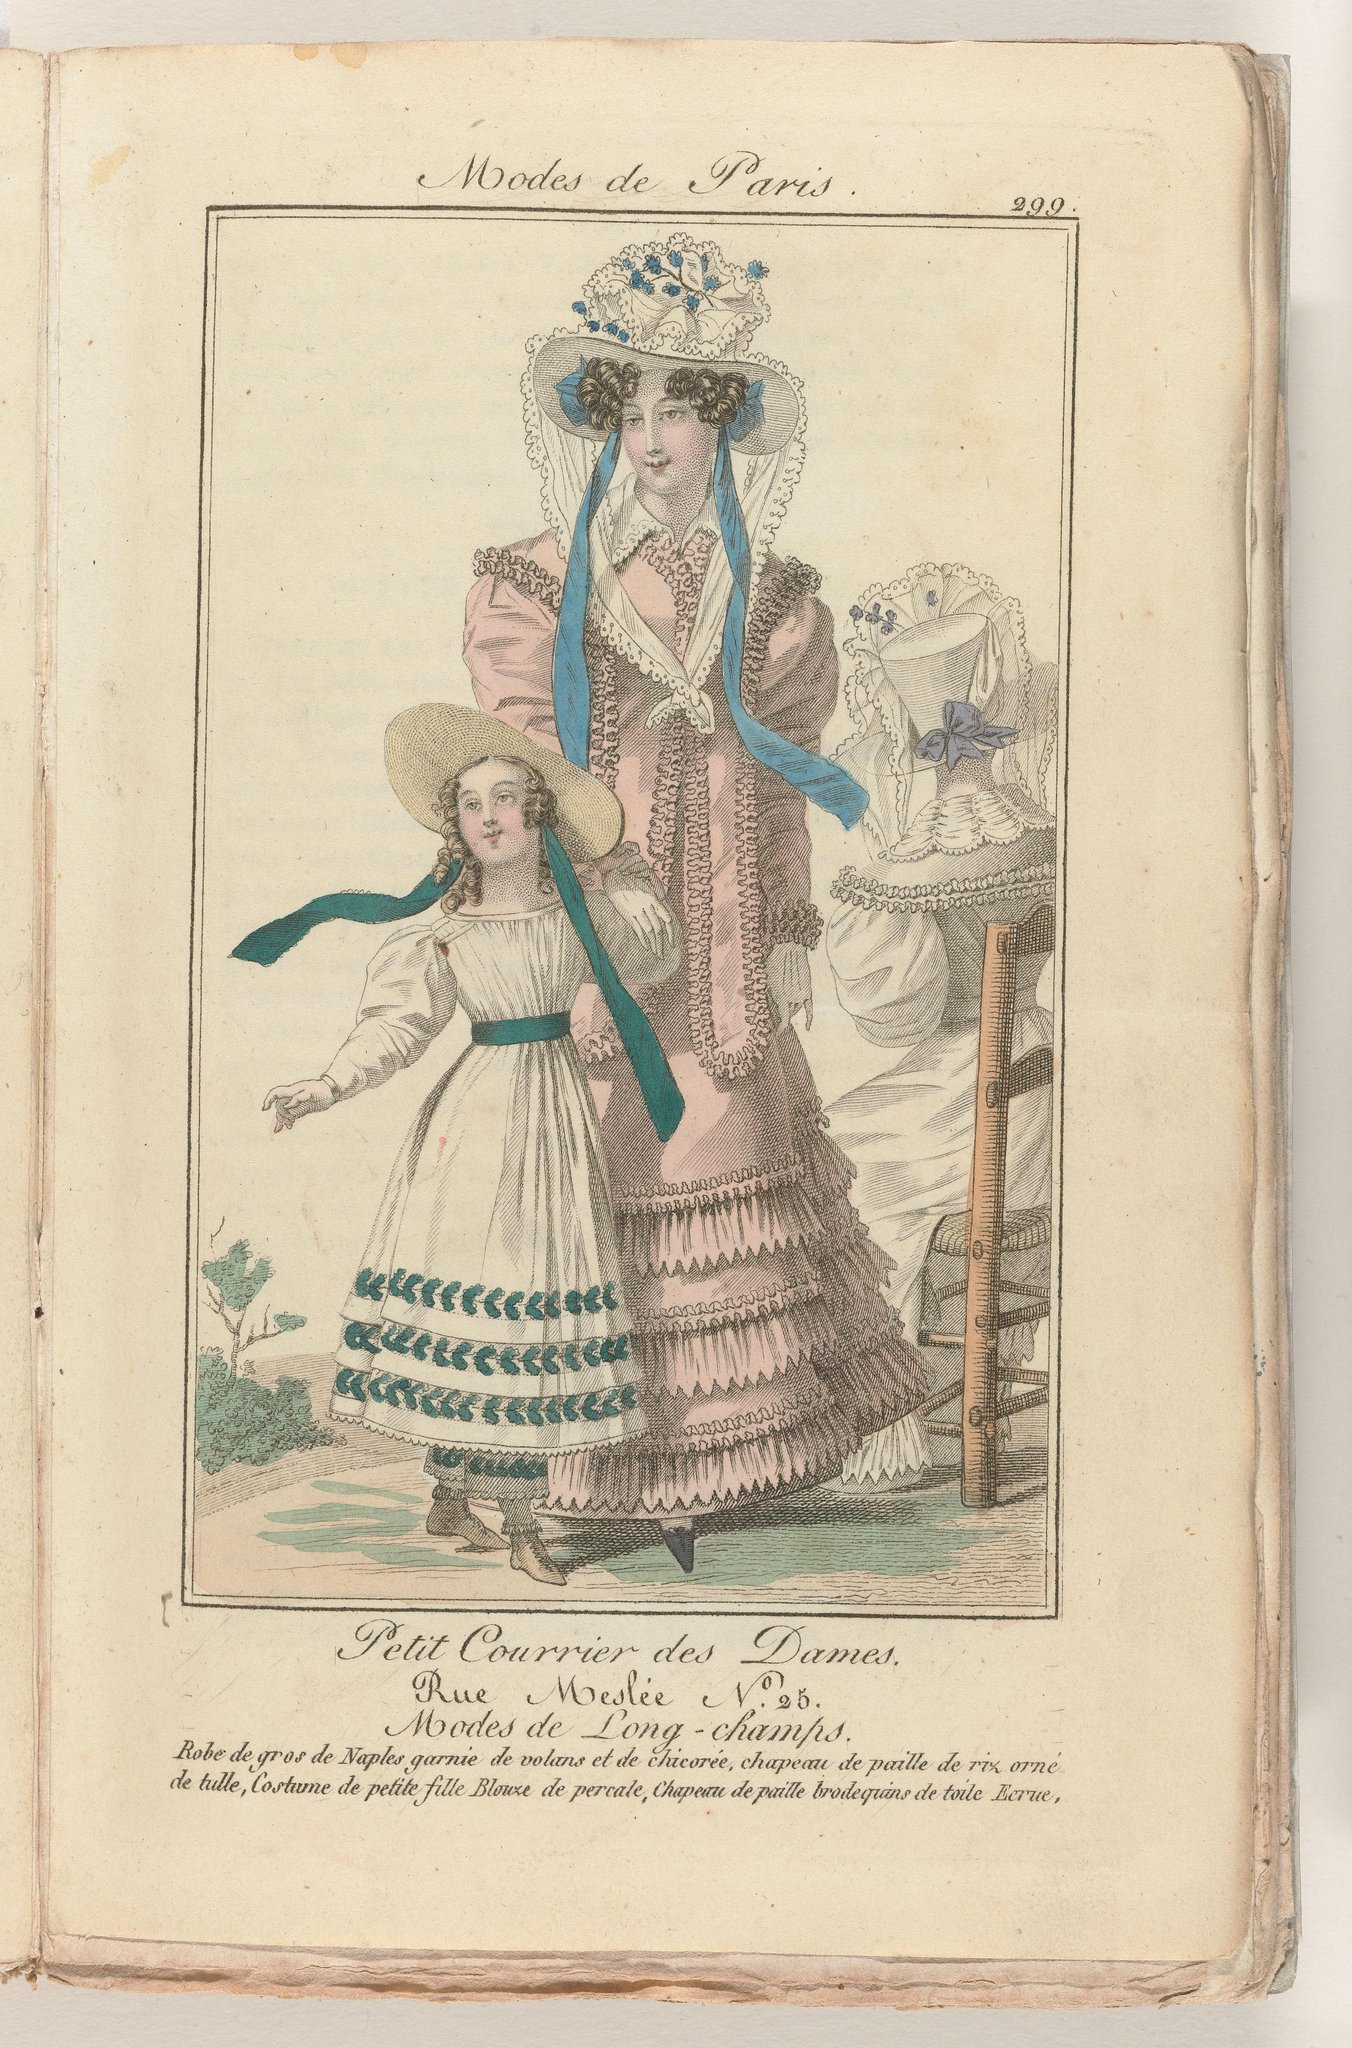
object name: fashion print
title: Petit Courrier des Dames 1825 (299)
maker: Anonymous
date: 1825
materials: paper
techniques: engraving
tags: fashion plates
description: Prent uit het modetijdschrift Petit Courrier des Dames (1821-1868).